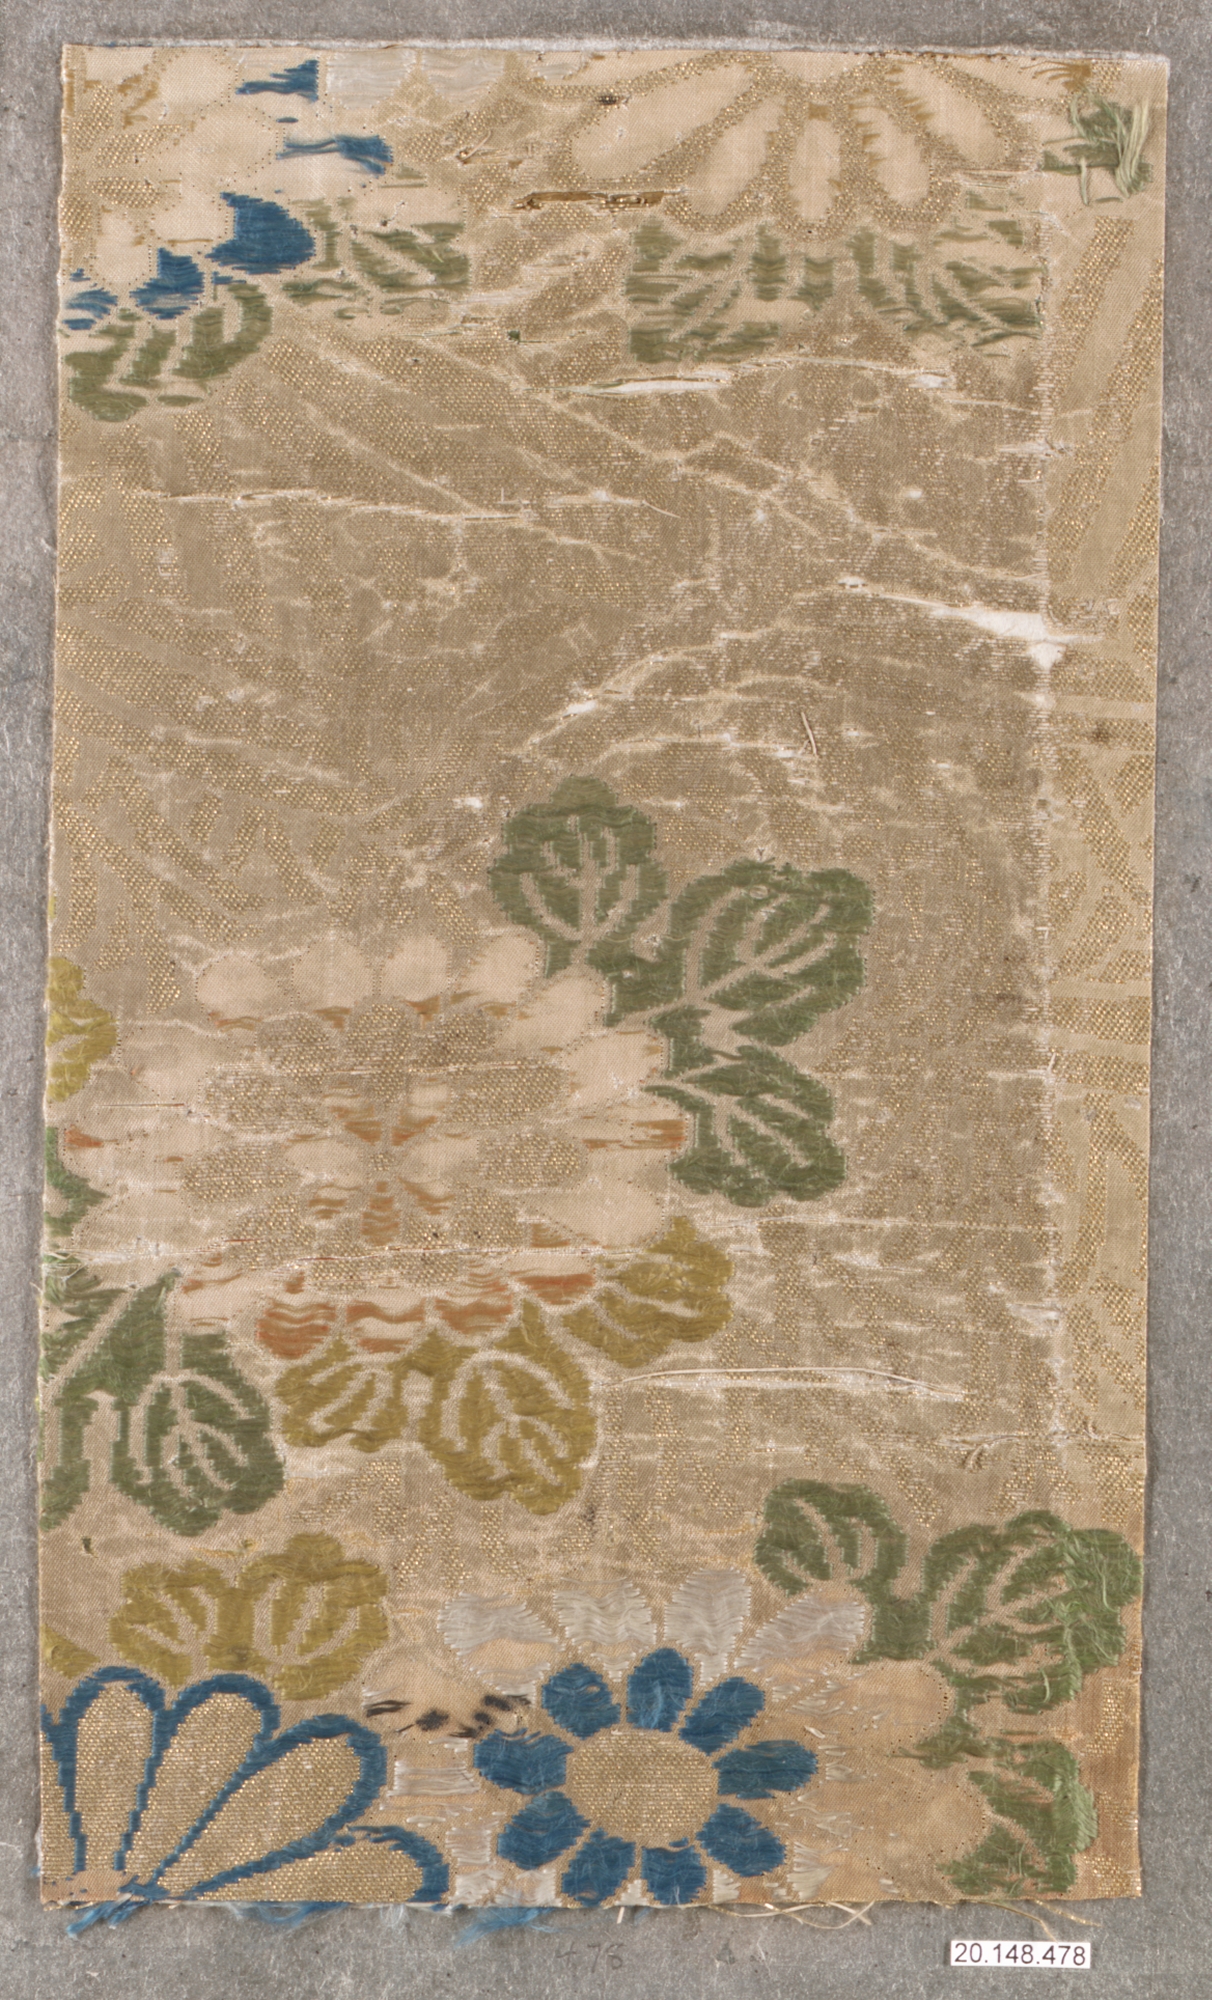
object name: piece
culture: japanese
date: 1601-1700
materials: silk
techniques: compound weave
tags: flowers,leaves